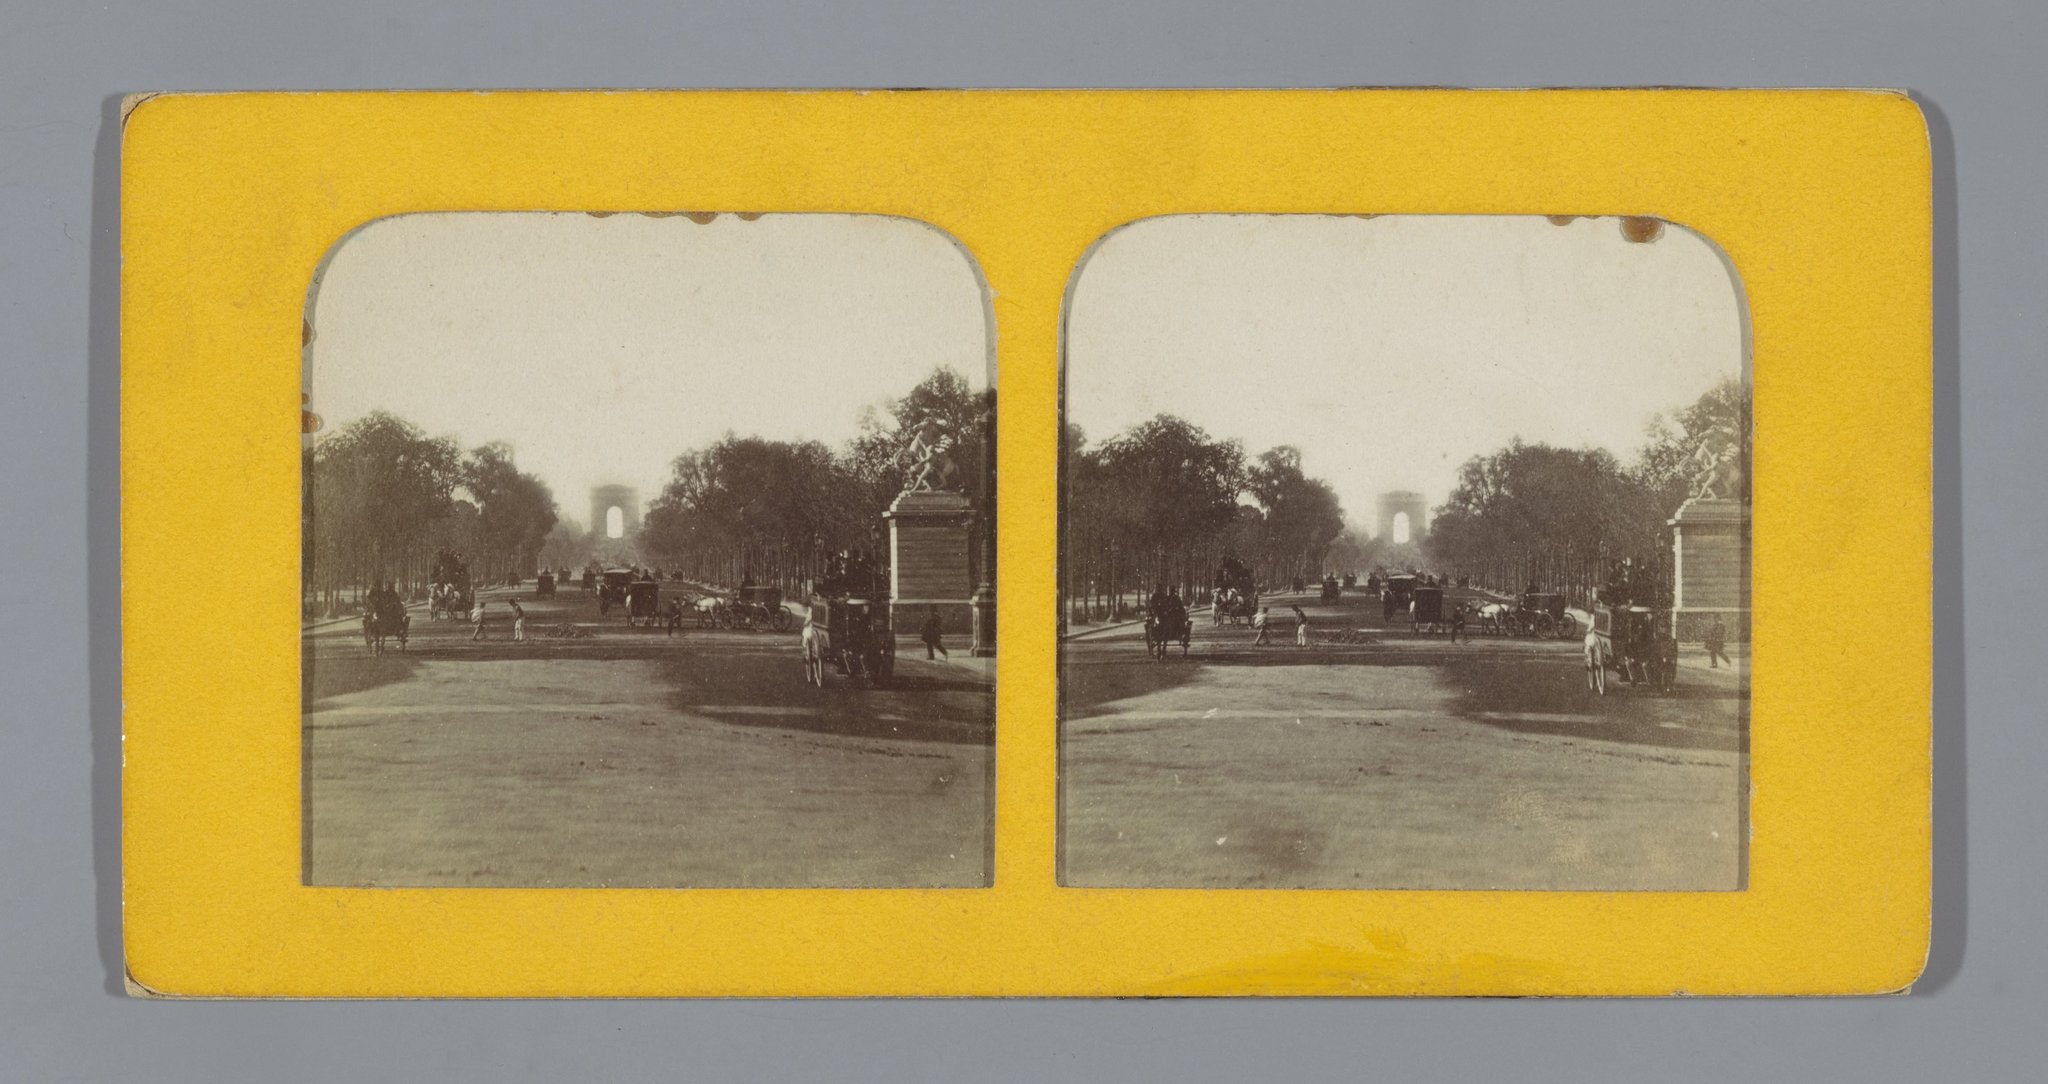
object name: tissue stereograph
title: Champs Elysées, Paris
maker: Anonymous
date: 1855-1875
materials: cardboard, paper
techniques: albumen print, hand coloring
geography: paris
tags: avenue, boulevard, promenade, esplanade